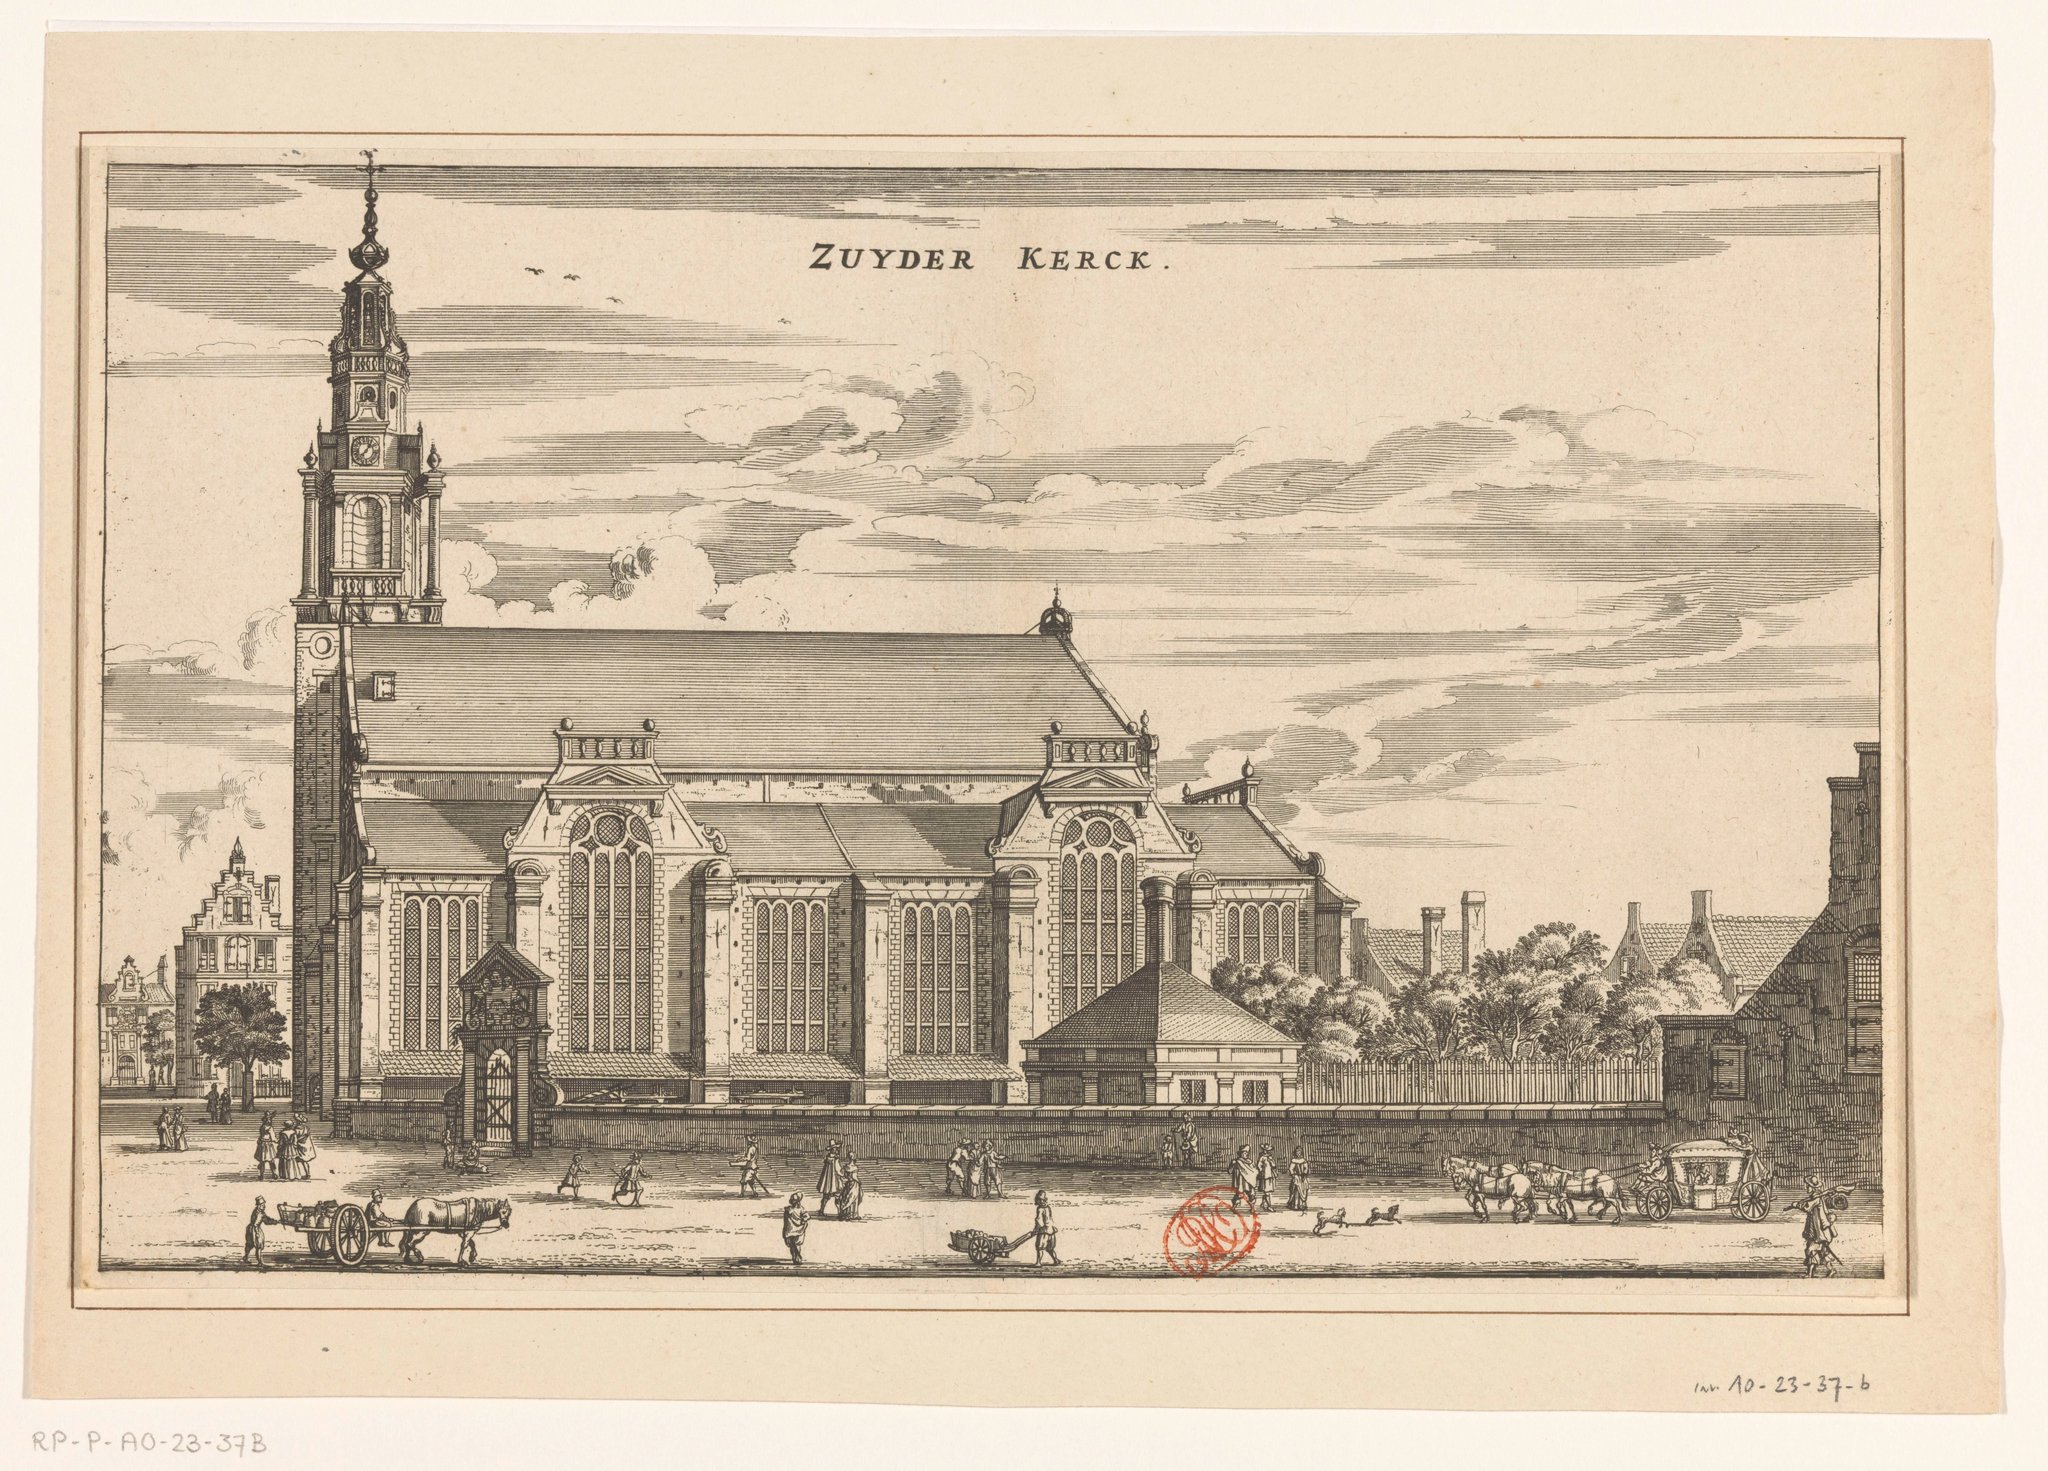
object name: print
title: Zuyder Kerck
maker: jacob van meurs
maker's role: draughtsman, print maker, publisher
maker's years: 1619-1680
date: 1663-1664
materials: paper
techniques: engraving, etching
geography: amsterdam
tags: church (exterior), street (+ city(-scape) with figures, staffage)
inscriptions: collector's mark: Lugt 195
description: Huidige staat van prent ook gebruikt in: Dapper, Olfert. Historische beschryving der stadt Amsterdam: waer in de voornaemste geschiedenissen (na een kort verhael van gansch Hollant en d'omleggende dorpen (…). Amsterdam: Jacob van Meurs, 1663.* En in: Zesen, Philipp von. Beschreibung der Stadt Amsterdam: darinnen von derselben ersten Ursprunge bis auf gegenwärtigen Zustand (…). Amsterdam: Joachim Nosche, 1664. * In sommige exemplaren van deze uitgave komt de huidige staat van de prent voor. In andere exemplaren is een latere staat ingebonden, waarop boven de Nederlandse een Franse titel is toegevoegd.